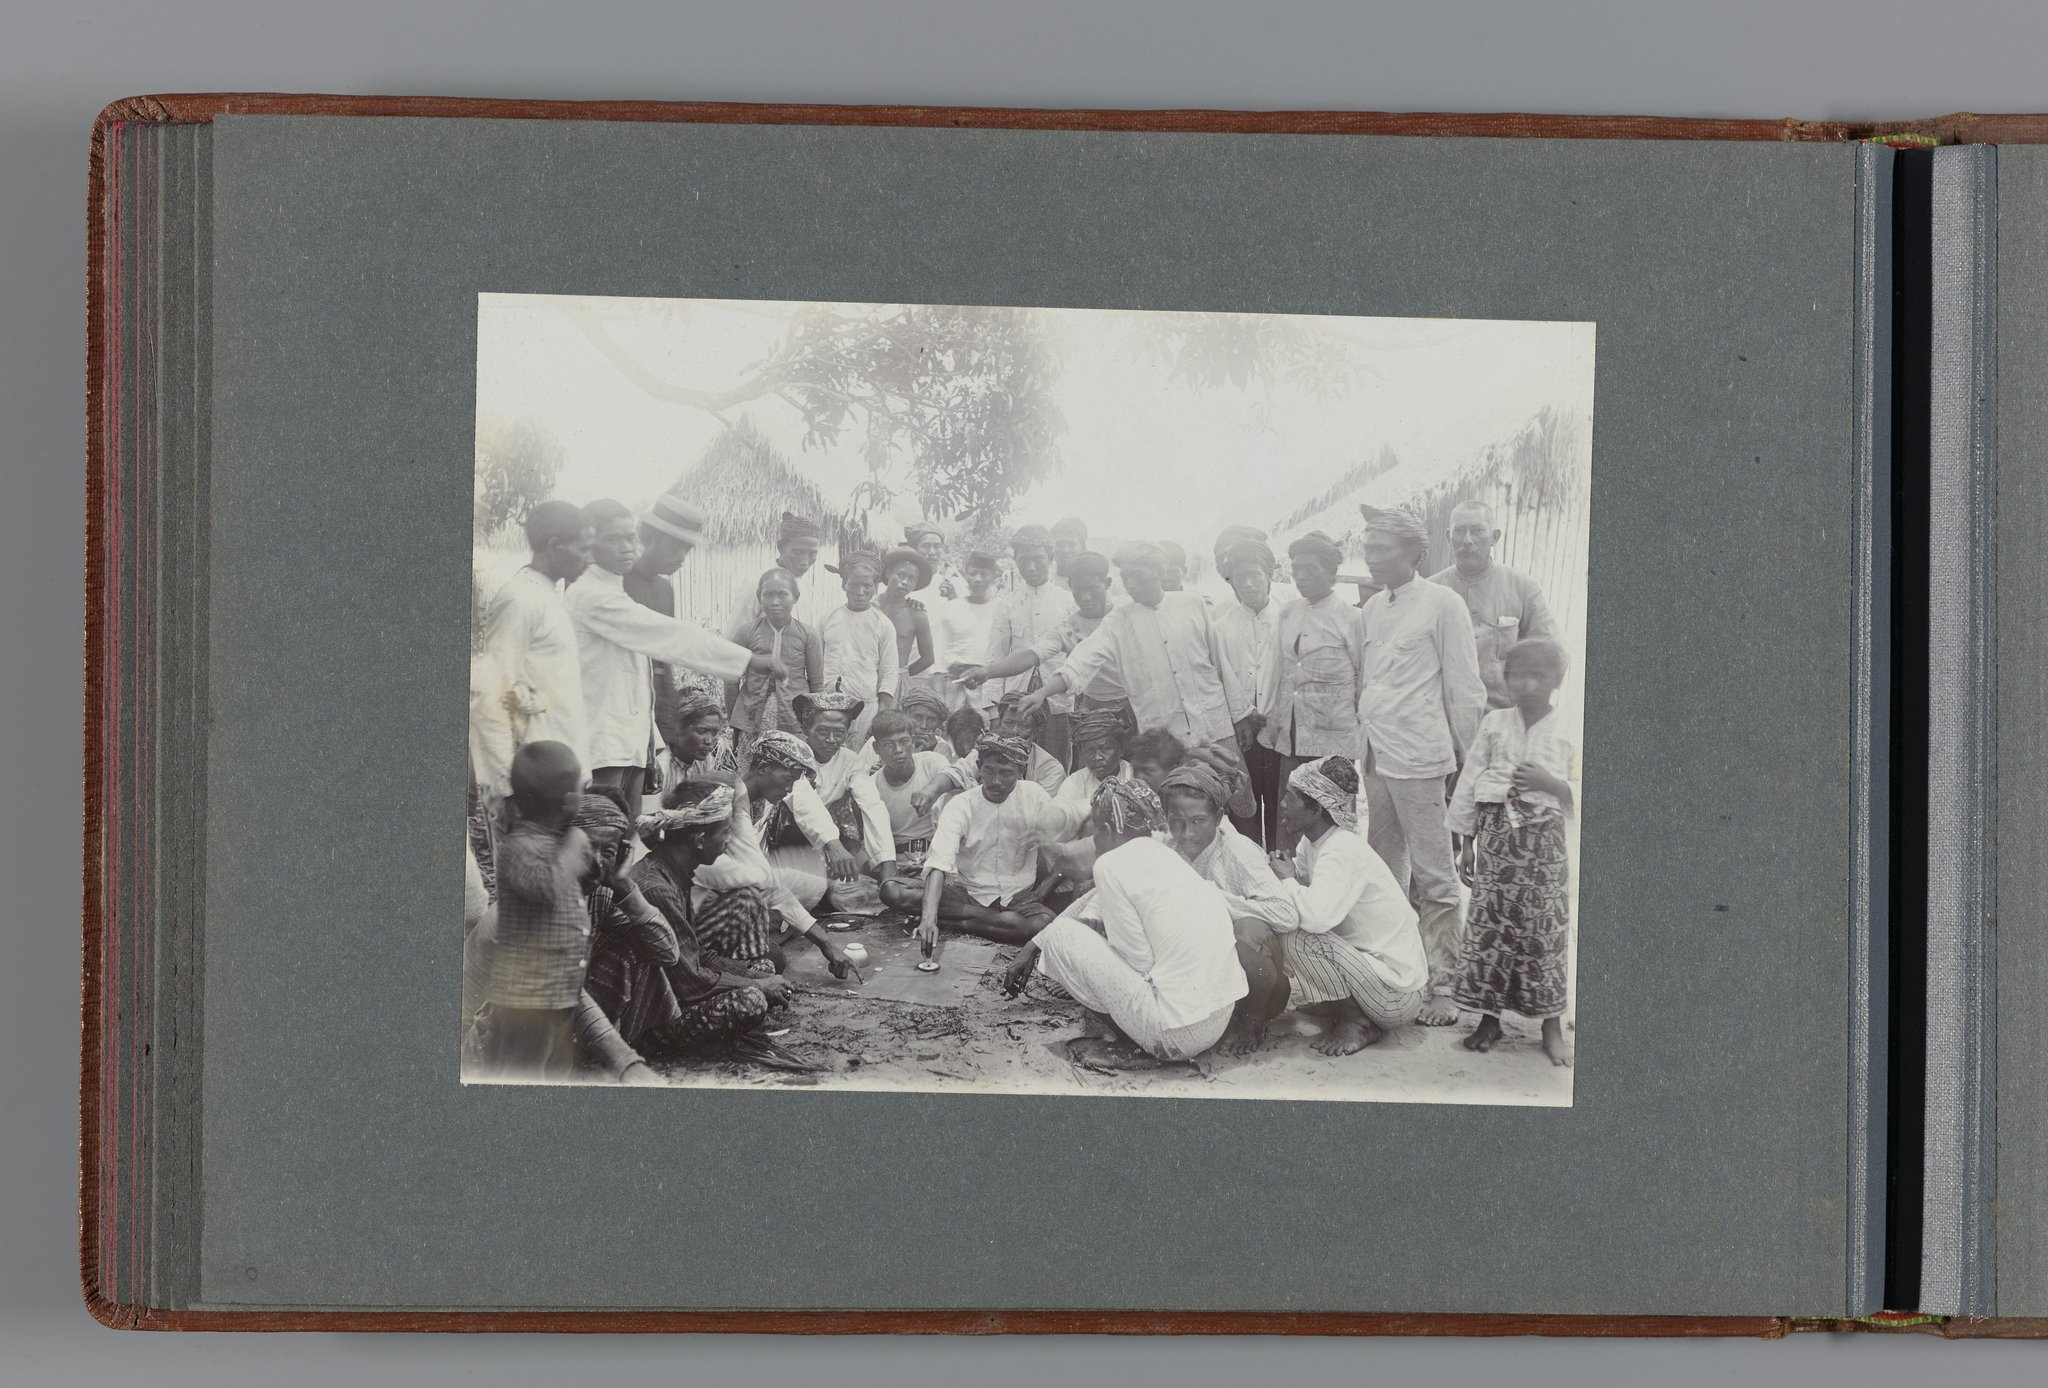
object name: photograph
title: Groep mannen - een deel zit en een deel staat, die een spel spelen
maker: Anonymous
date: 1905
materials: cardboard, paper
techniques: photography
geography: paramaribo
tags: suriname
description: Groep mannen - een deel zit en een deel staat, die een spel spelen. Onderdeel van fotoalbum 'Suriname'.